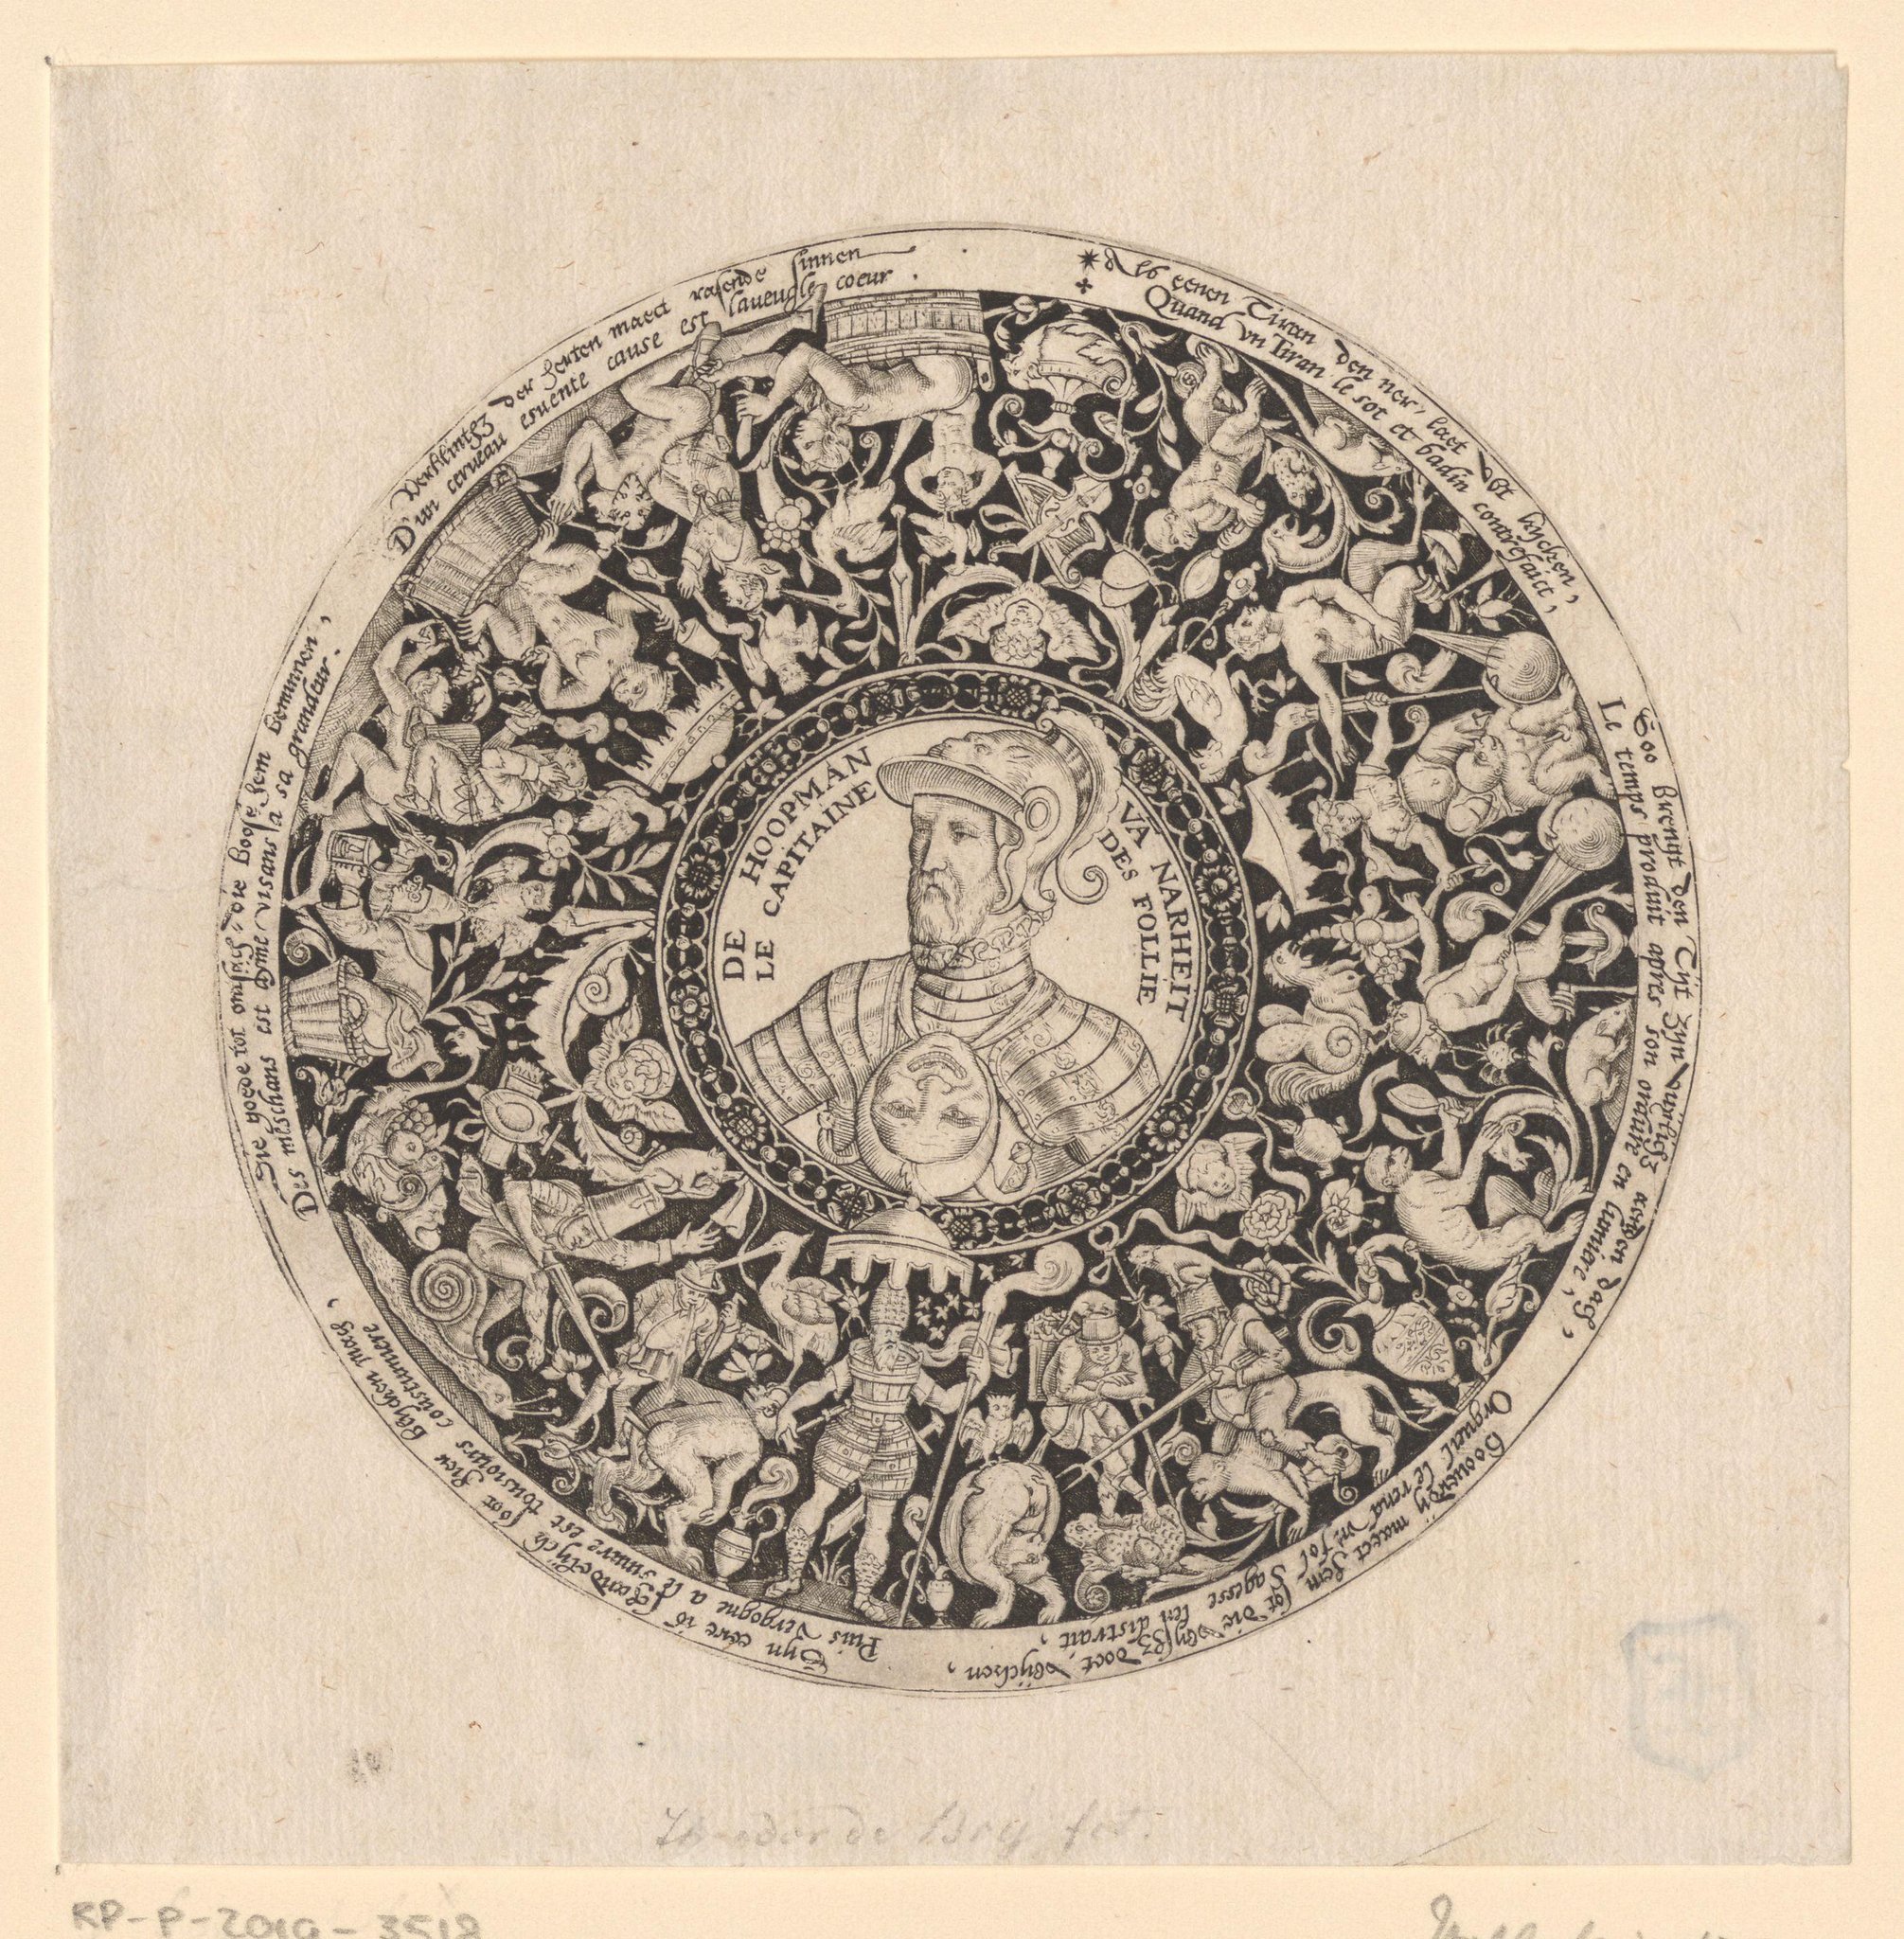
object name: print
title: De hoopman van narheit / Le capitaine des follie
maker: theodor de bry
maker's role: draughtsman, print maker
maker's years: 1528-1598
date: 1588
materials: paper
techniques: engraving, etching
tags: fernando álvarez de toledo (3rd duke of alba), helmet, musical instruments; group of musical instruments, fabulous animals (sometimes wrongly called 'grotesques'); 'mostri' (ripa), monkeys, apes, birds, armour, historical persons, owls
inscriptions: collector's mark: Lugt 2612, collector's mark: Lugt 963